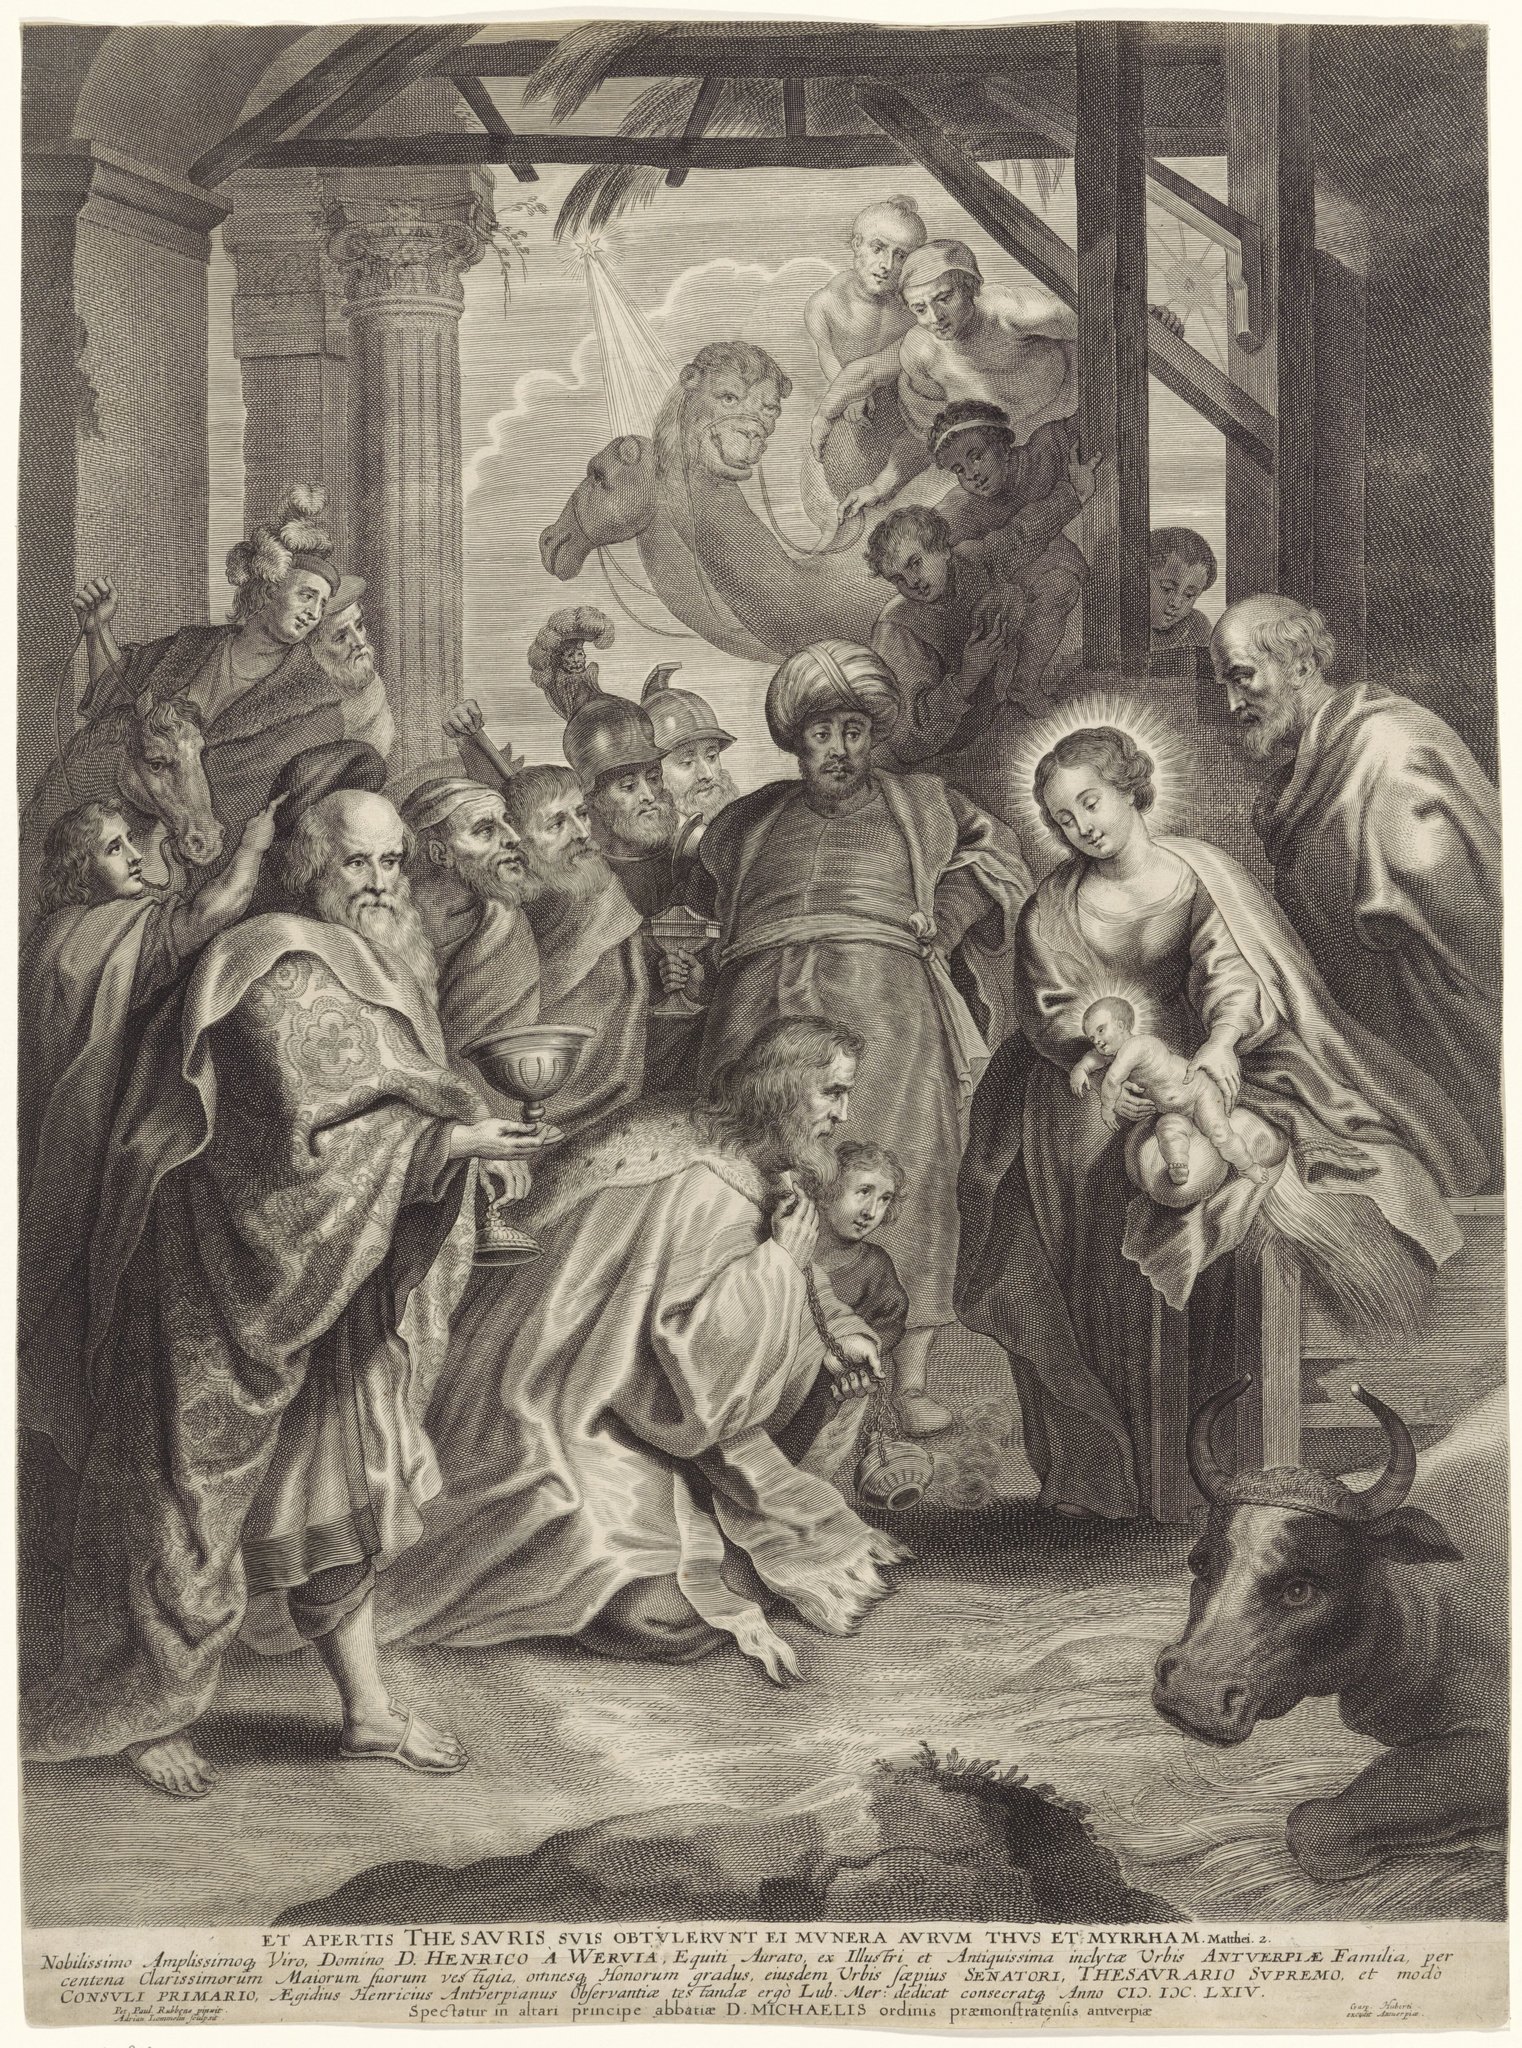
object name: print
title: Aanbidding der koningen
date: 1661-1684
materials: paper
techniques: engraving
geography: antwerp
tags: adoration of the kings: the wise men present their gifts to the christ-child (gold, frankincense and myrrh)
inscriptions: collector's mark: Lugt 240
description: Maria en Jozef tonen het Christuskind aan de drie koningen. De drie bieden het kind hun geschenken aan. Leden van hun gevolg kijken toe.